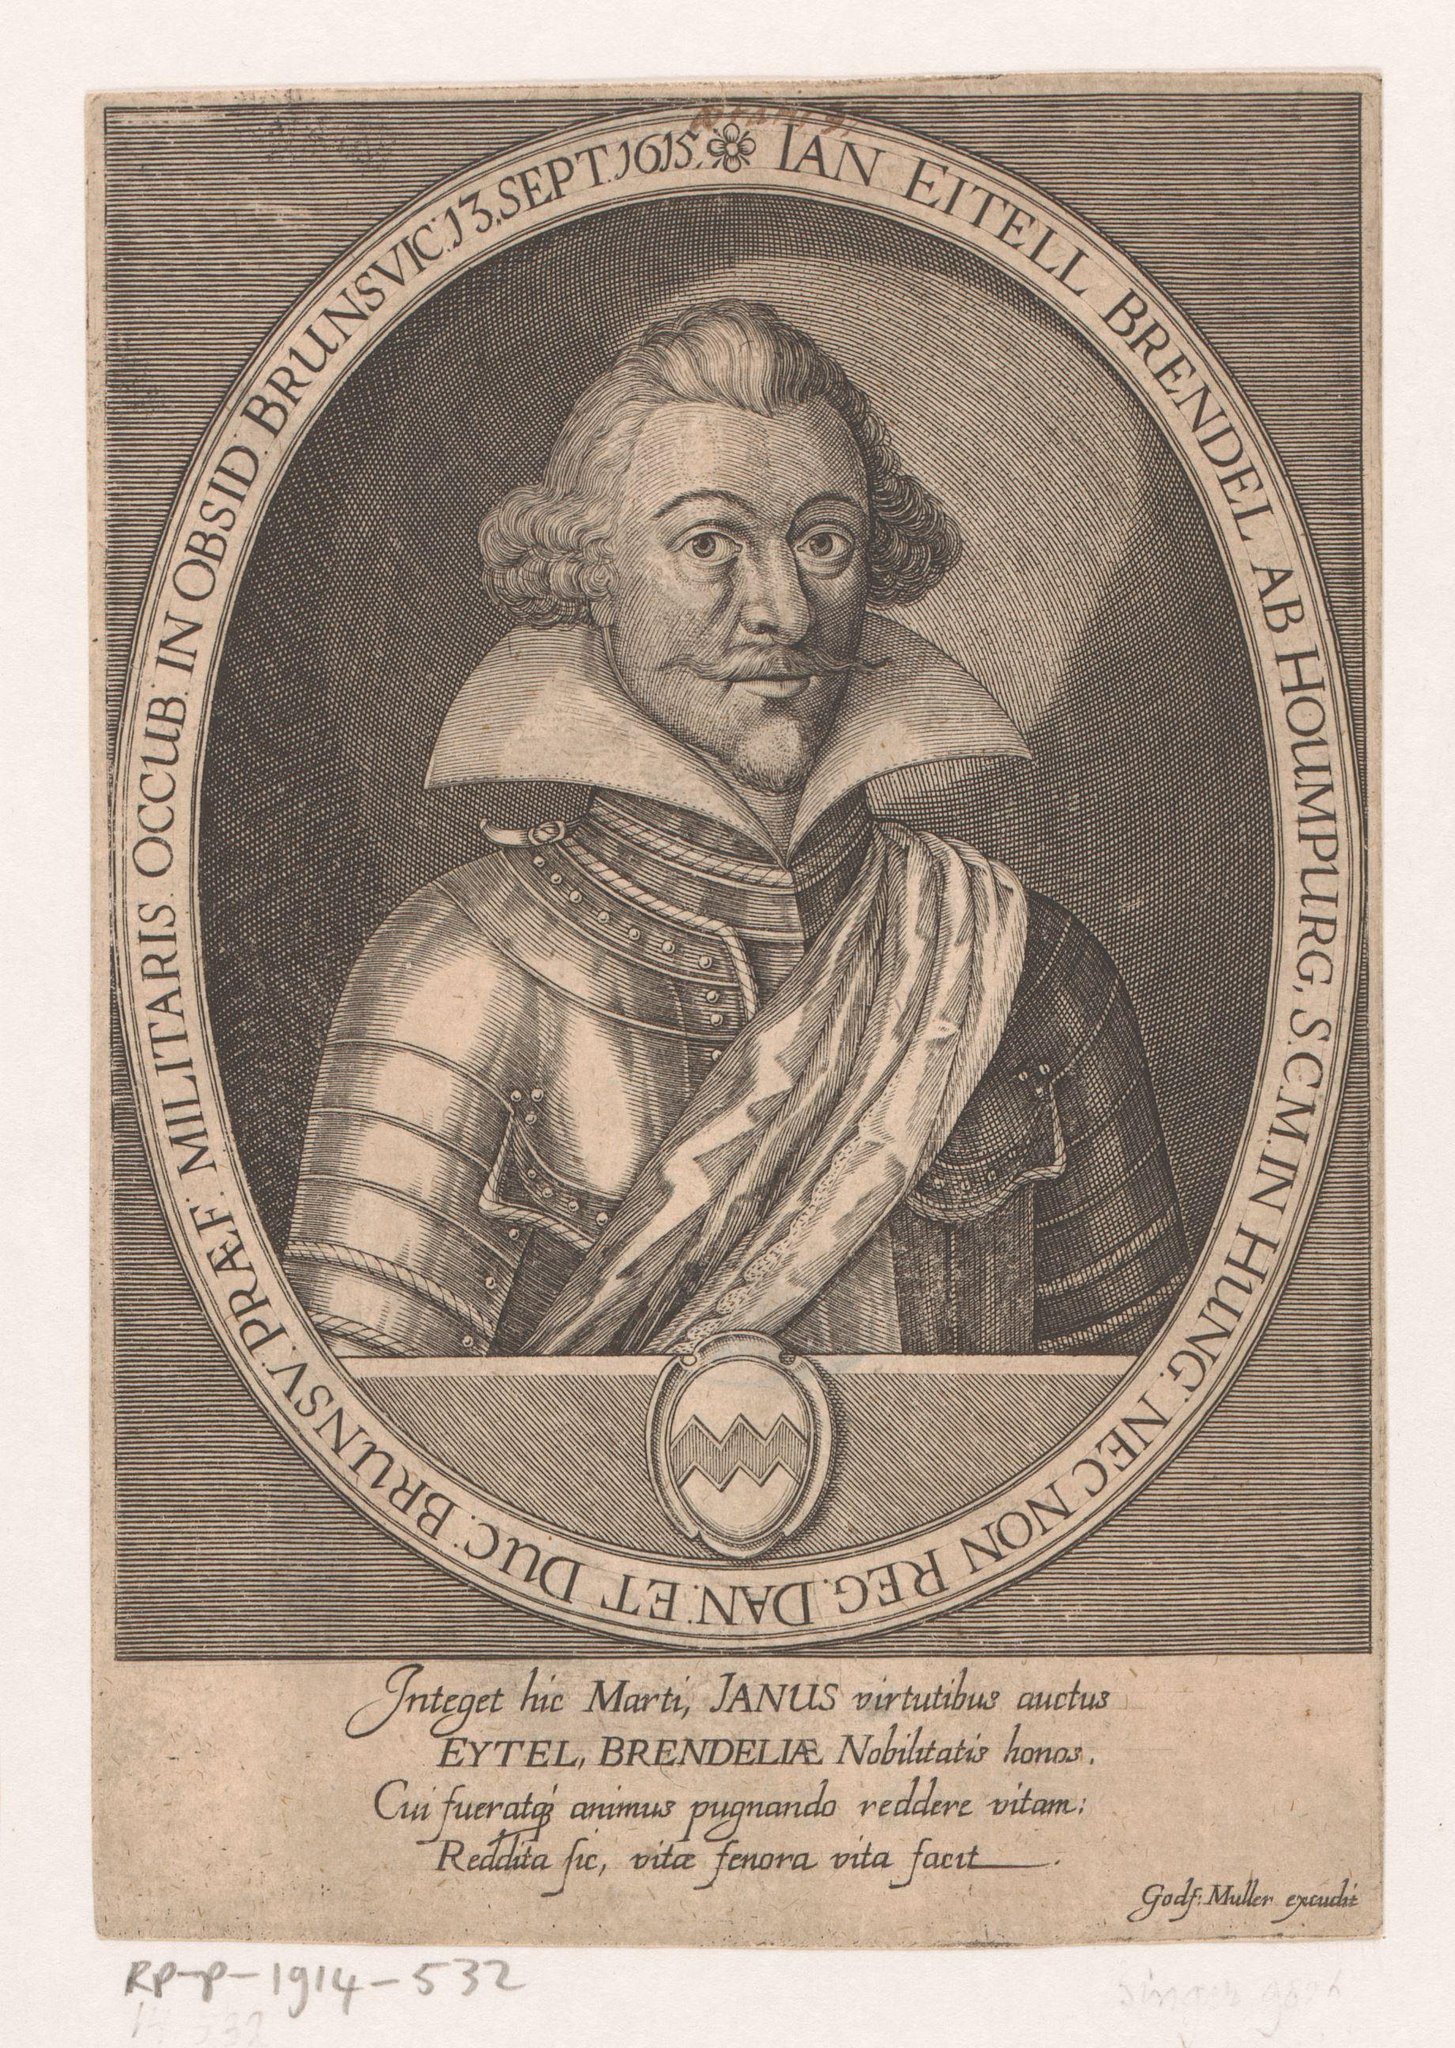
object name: print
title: Portret van Johann Eitel Brendel von Homburg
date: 1620-1656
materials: paper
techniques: engraving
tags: armour, historical persons, armorial bearing, heraldry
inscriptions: collector's mark: Lugt 2228